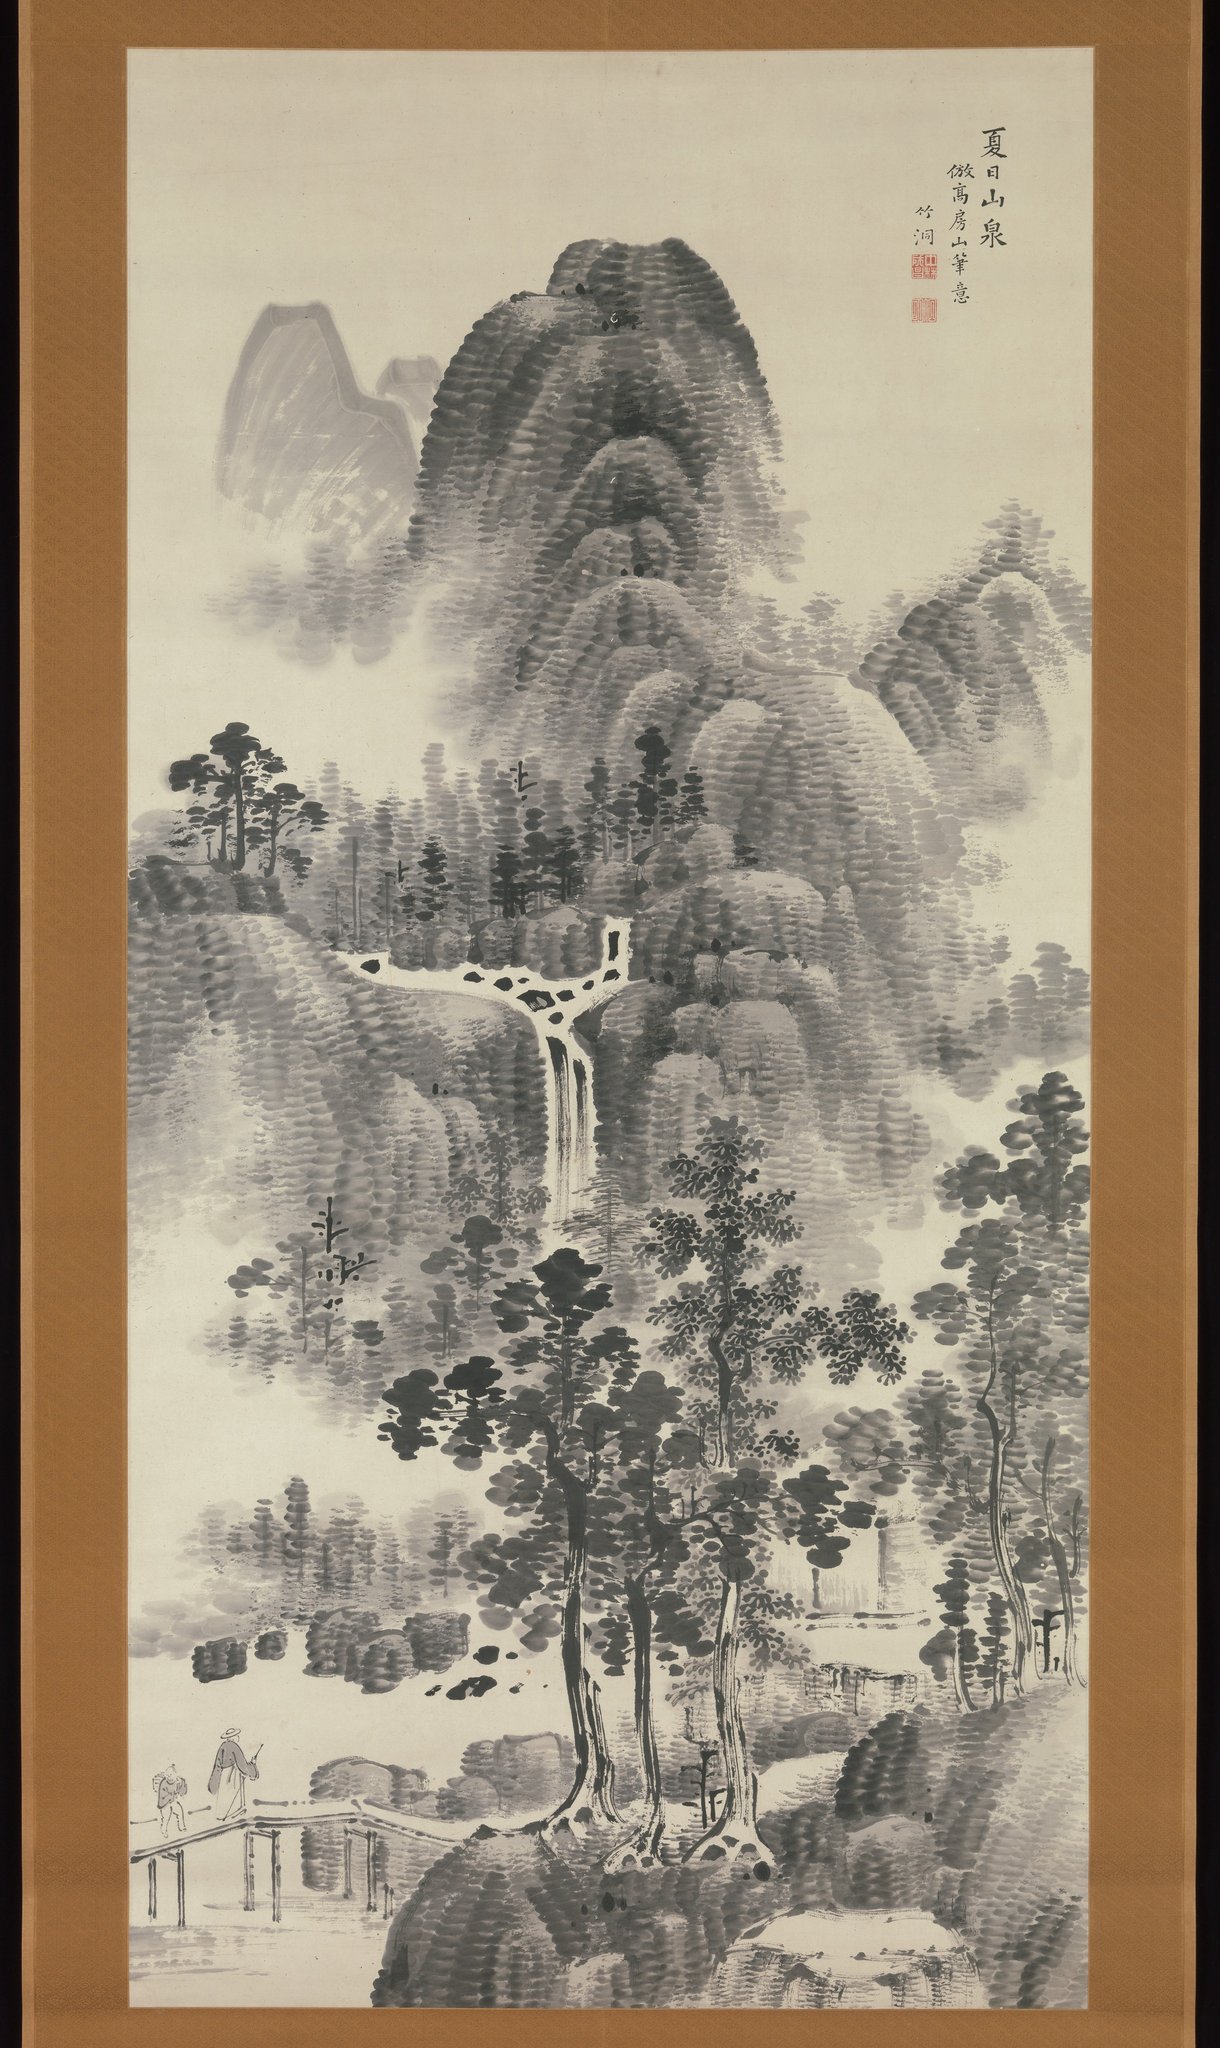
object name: hanging scroll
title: Mountain Stream on a Summer Day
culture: japanese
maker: nakabayashi chikutō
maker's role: artist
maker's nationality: japanese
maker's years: 1776-1853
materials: ink, paper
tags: bridges,waterfalls,mountains